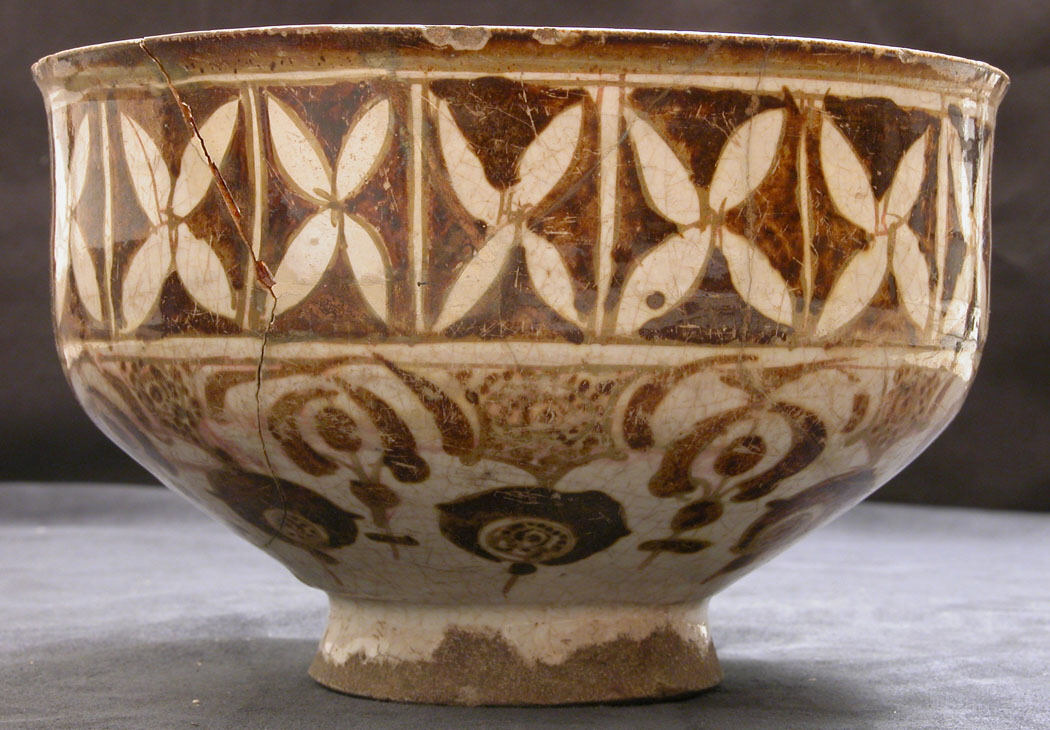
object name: bowl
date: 1101-1300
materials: stonepaste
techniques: luster painting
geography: iran